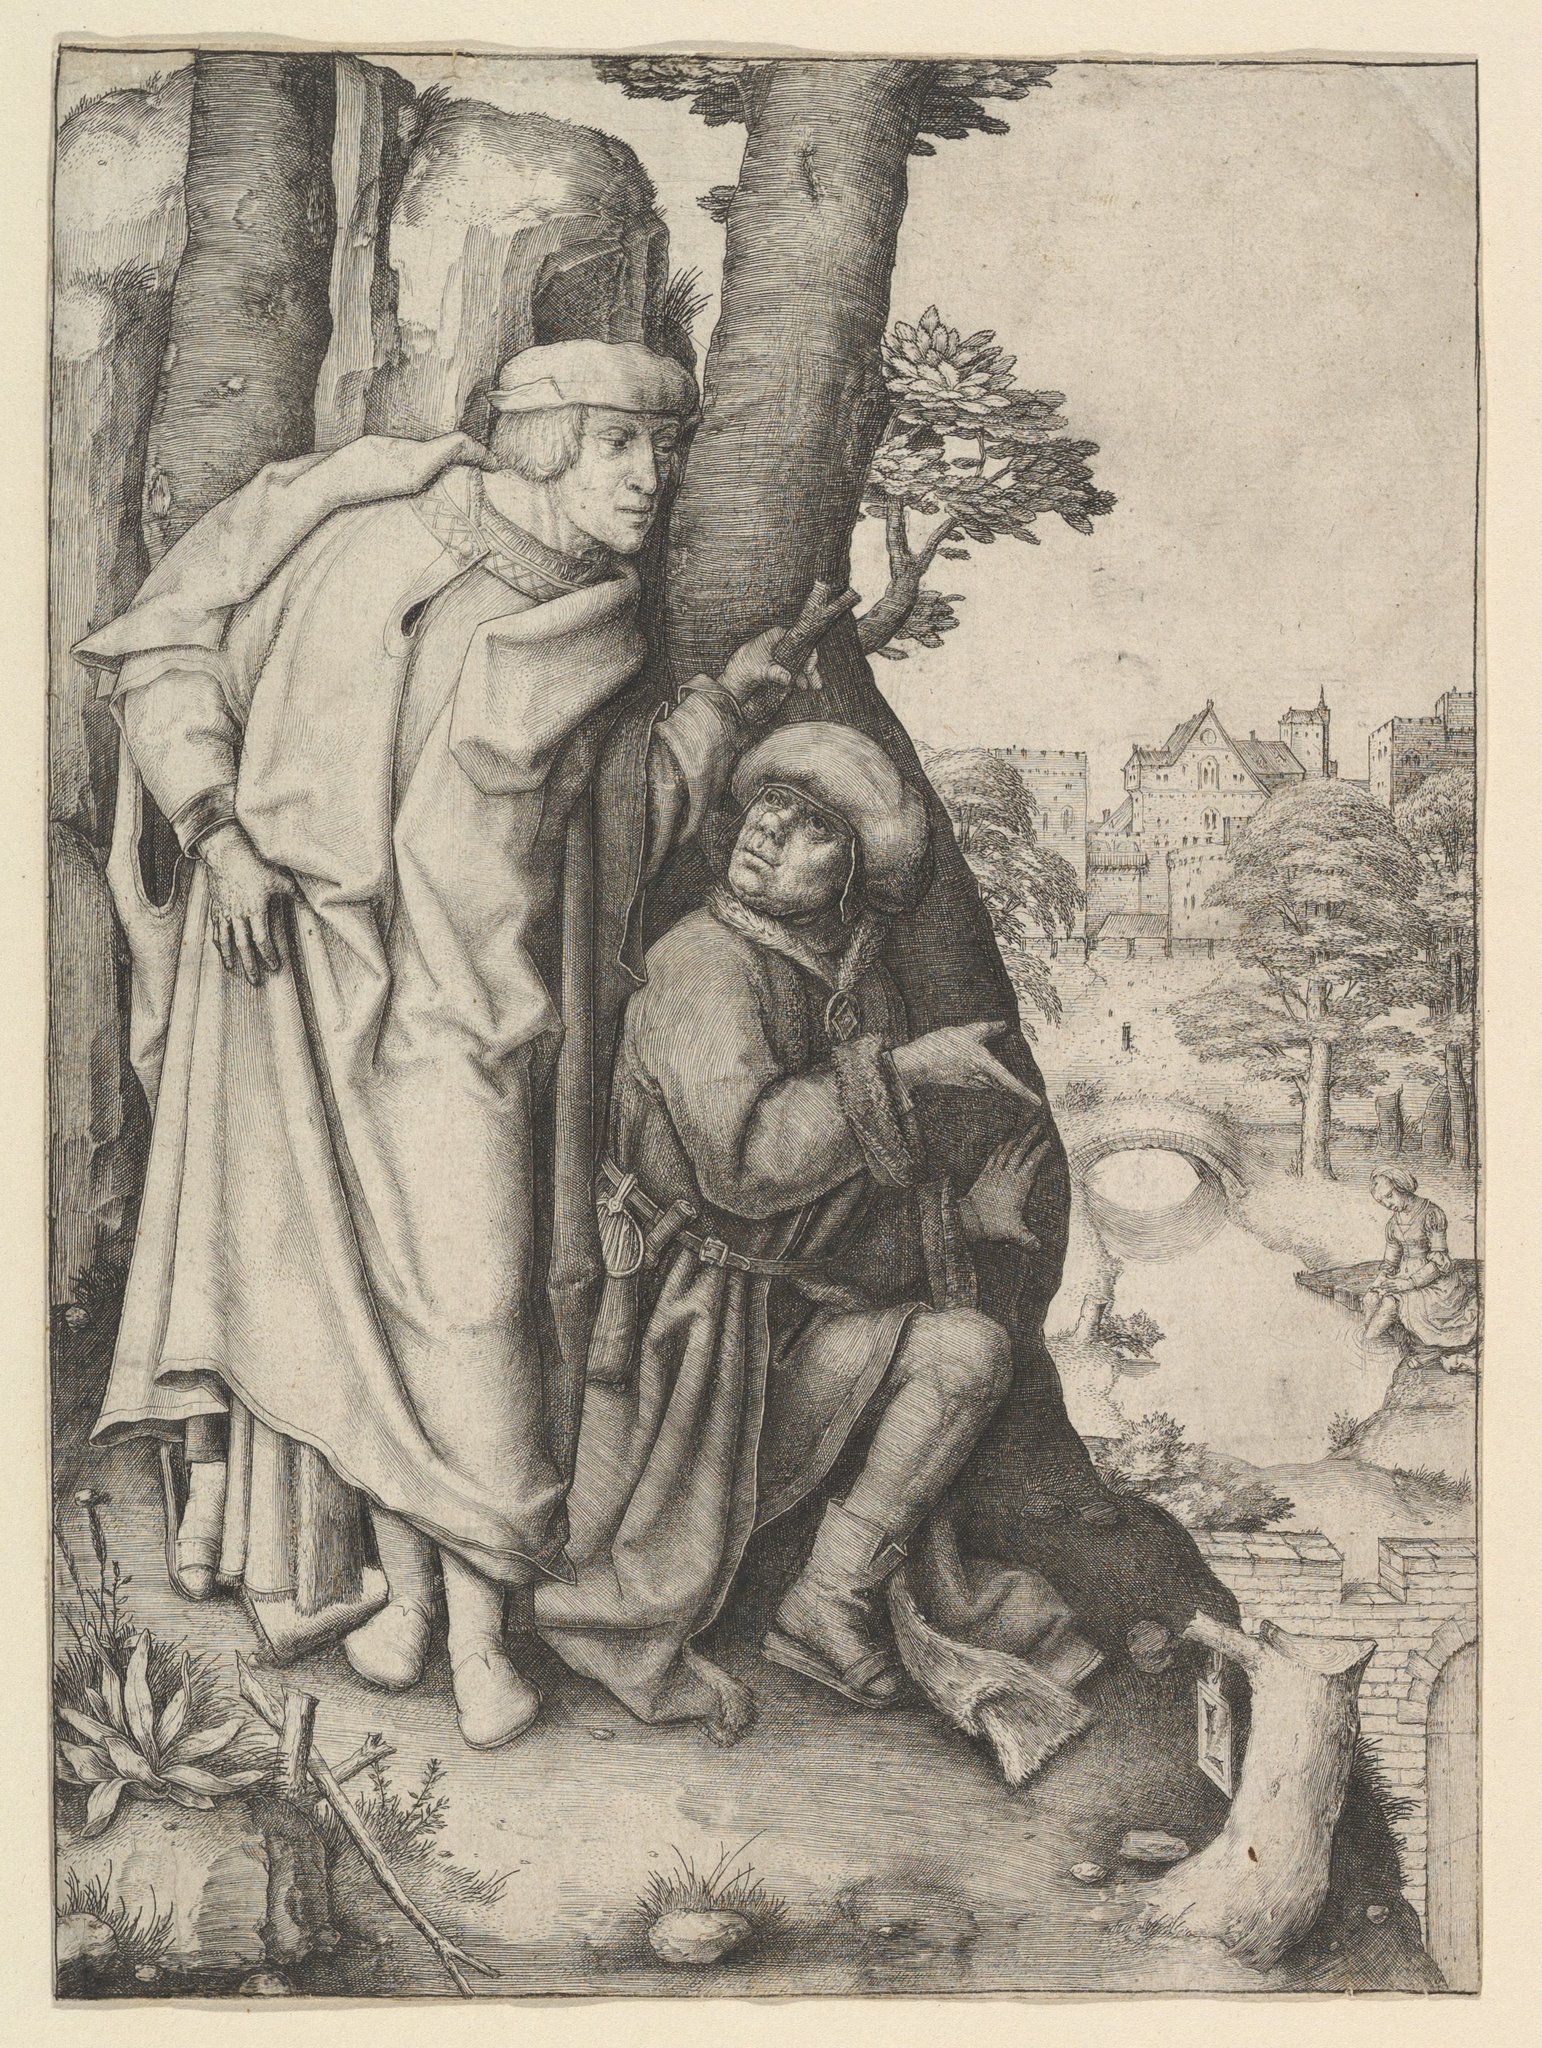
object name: print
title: Susanna and the Two Elders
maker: lucas van leyden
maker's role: artist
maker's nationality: netherlandish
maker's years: 1494-1533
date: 1508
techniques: engraving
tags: men,women